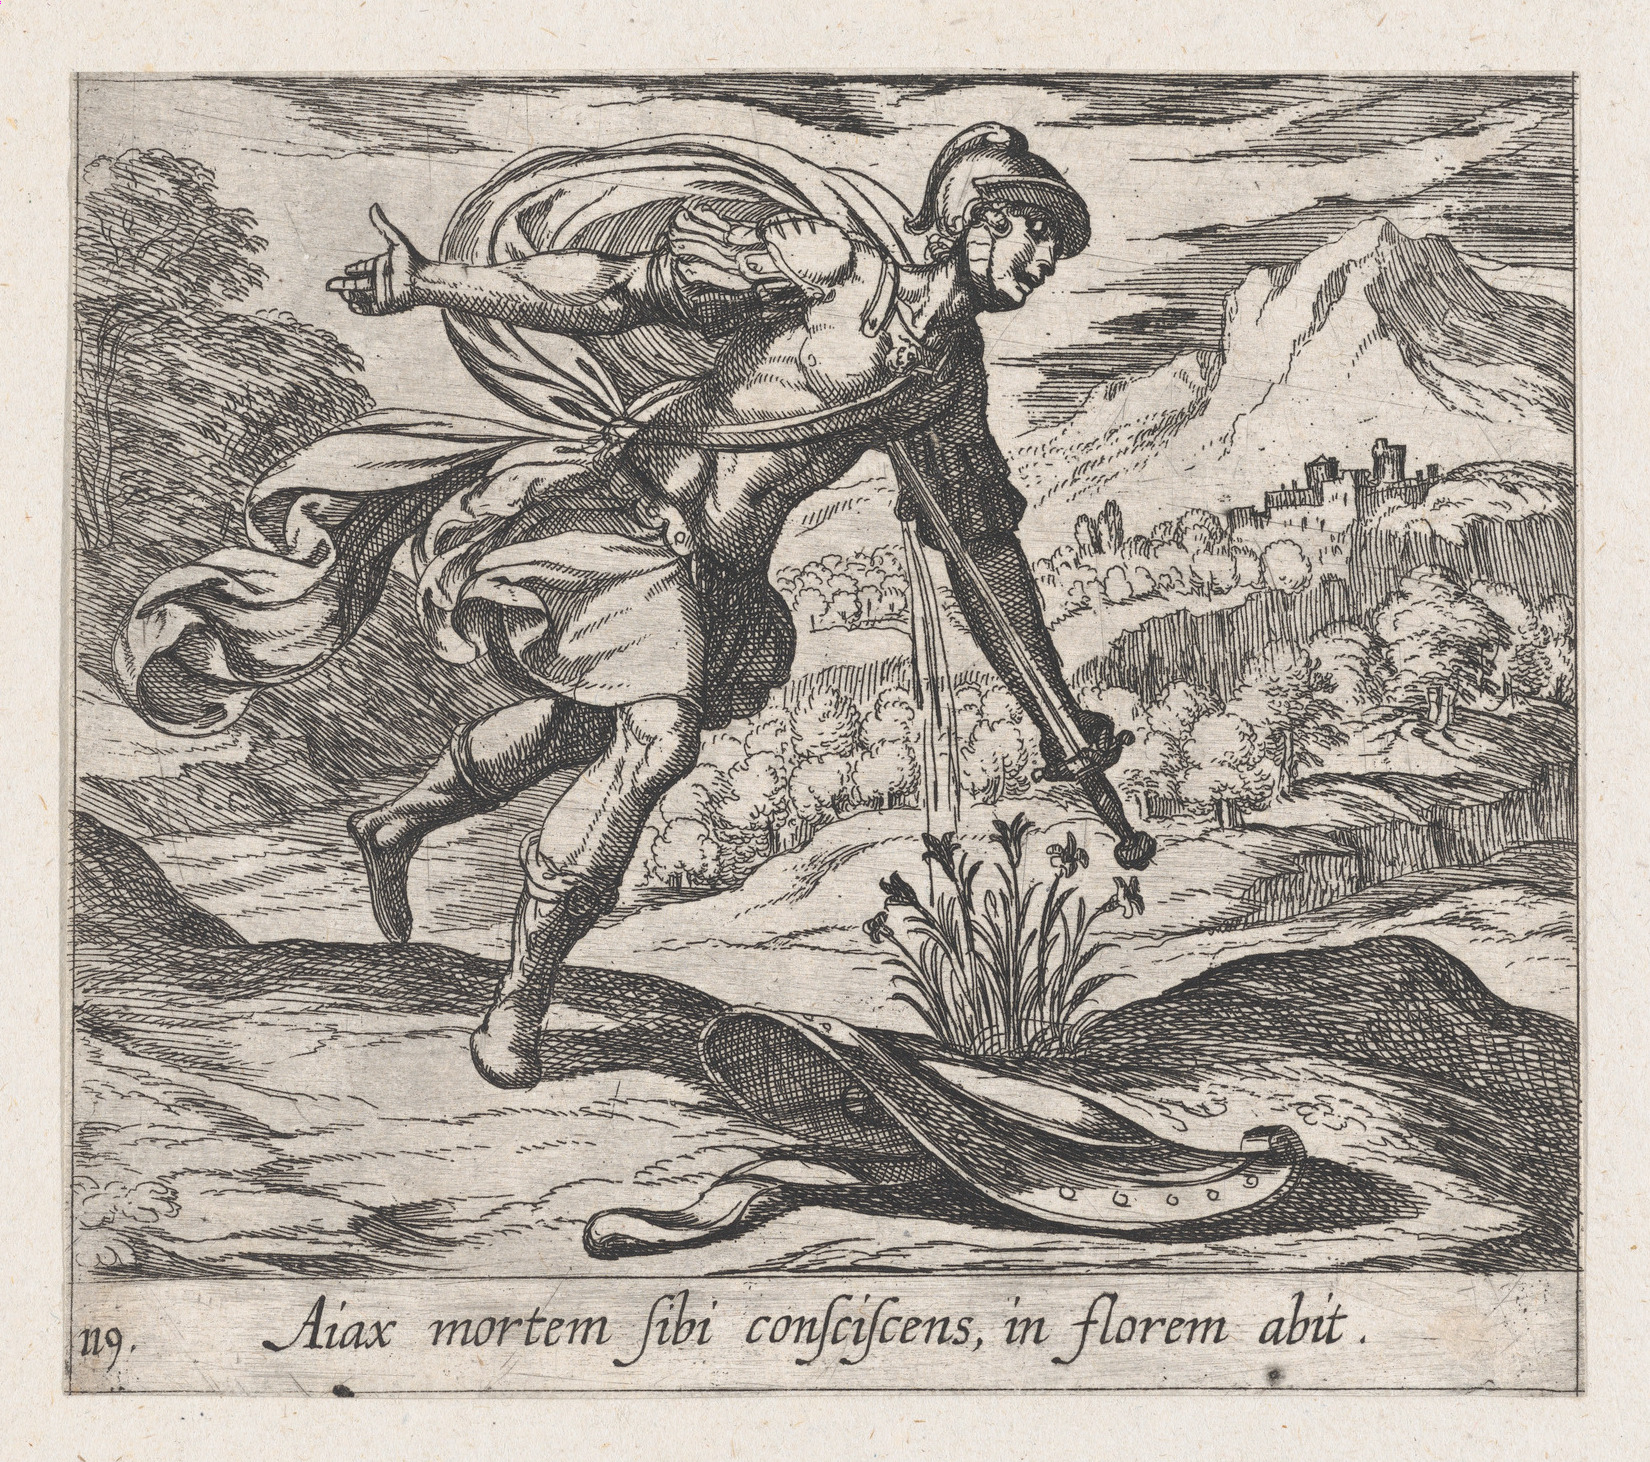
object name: print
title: Plate119: The Death of Ajax (Aiax moretm Sibi consciscens, in florem abit), from Ovid's 'Metamorphoses'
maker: antonio tempesta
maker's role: artist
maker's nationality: italian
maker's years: 1555-1630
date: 1606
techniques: etching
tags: soldiers,men